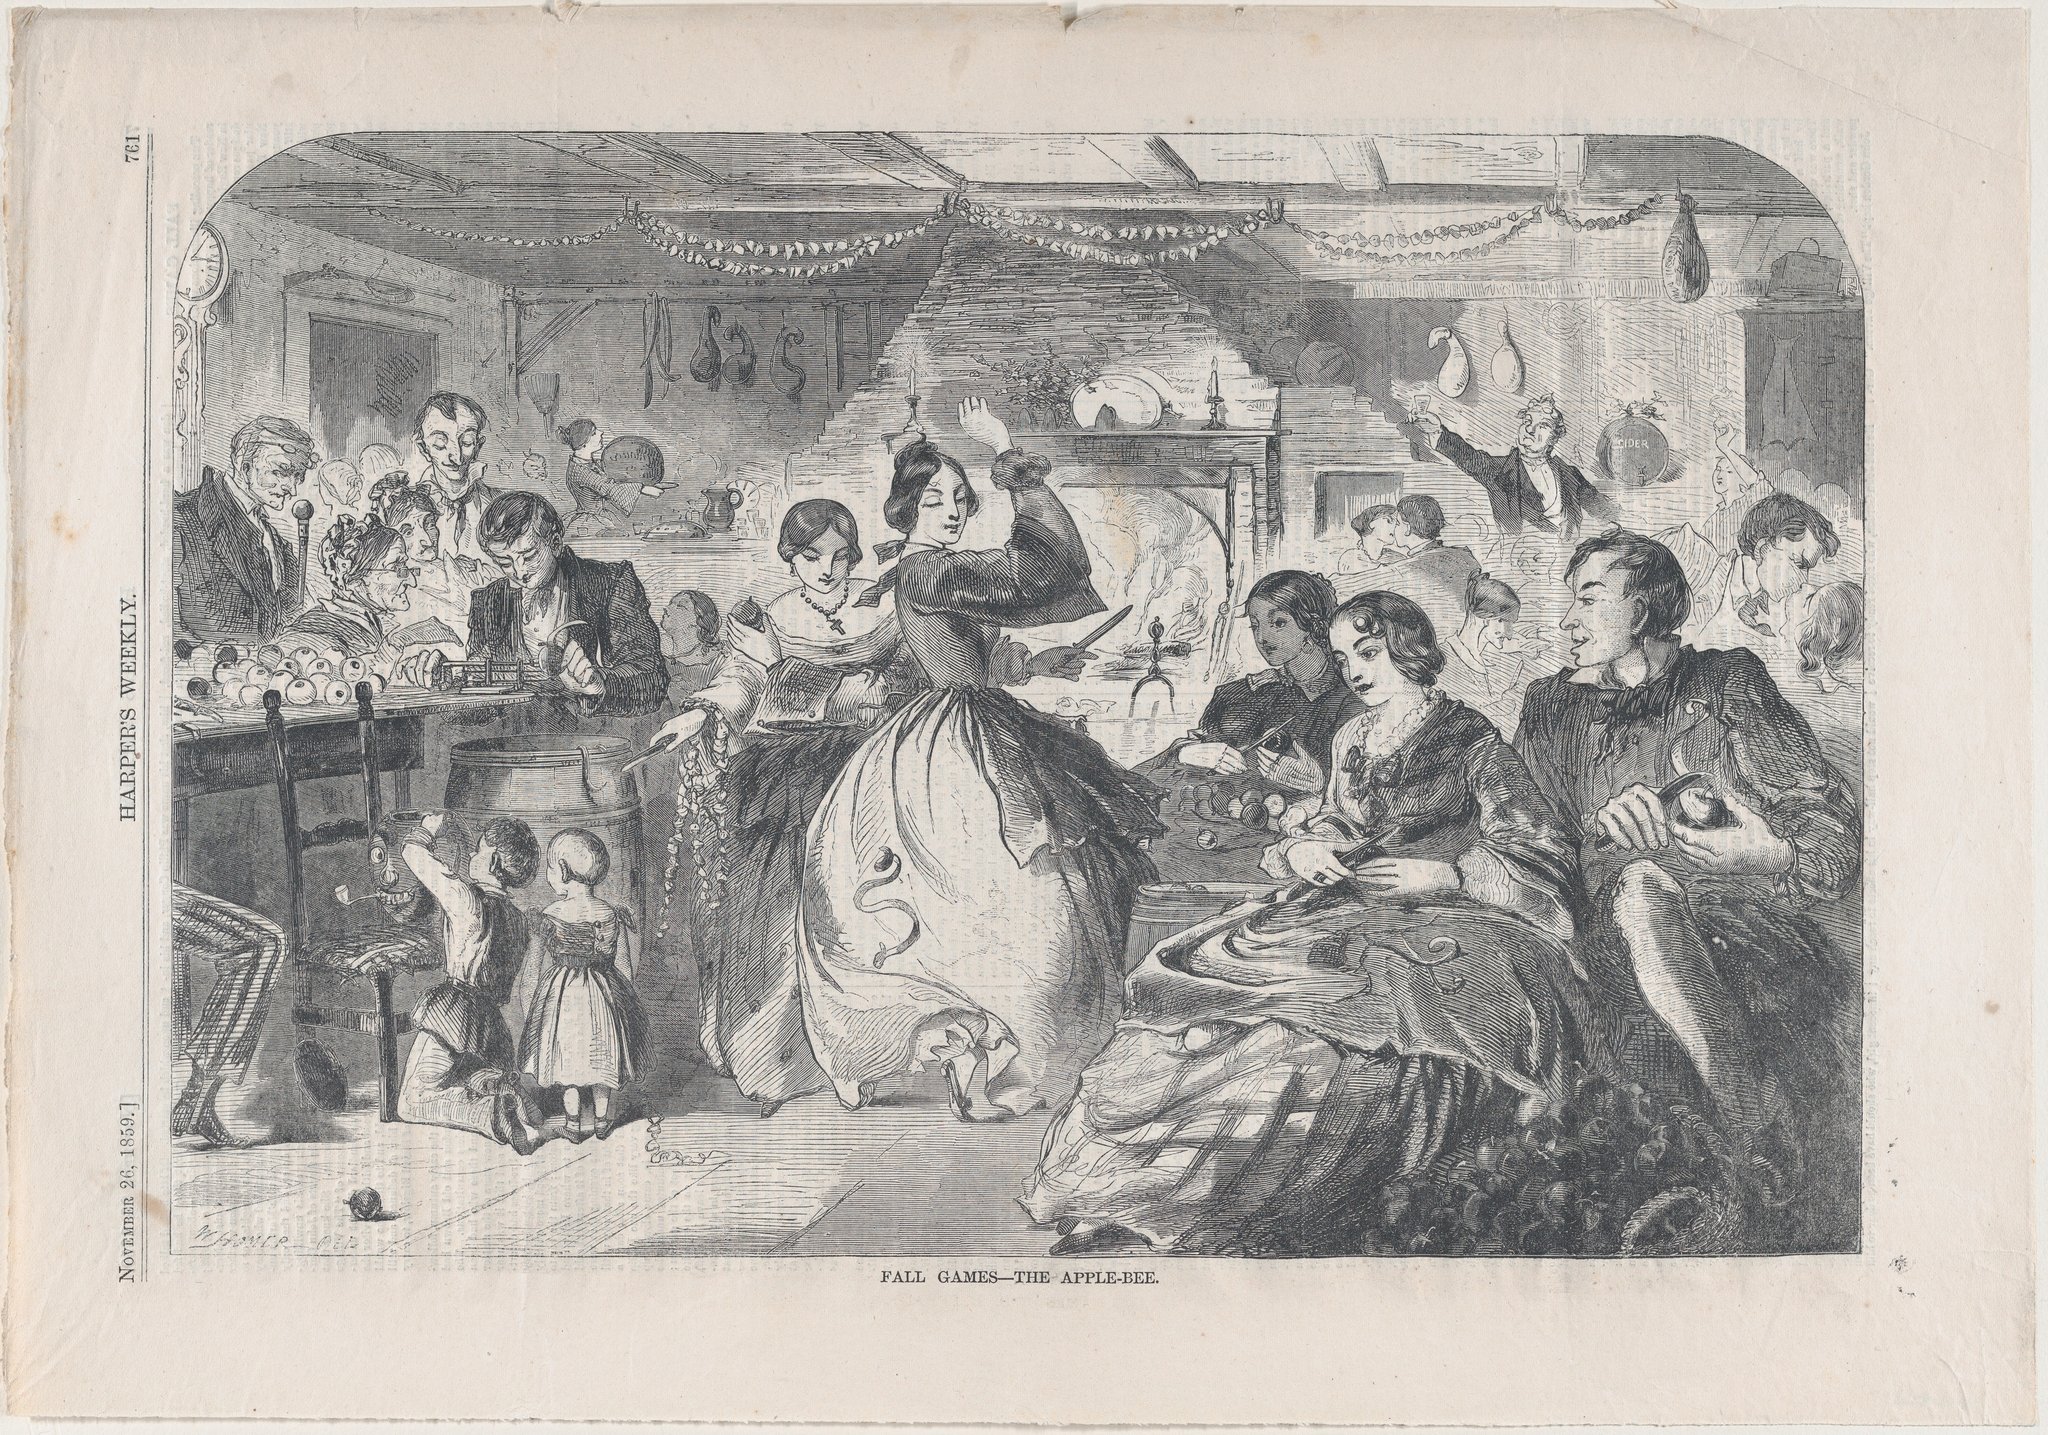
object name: print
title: Fall Games – The Apple Bee (from "Harper's Weekly," Vol. III)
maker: winslow homer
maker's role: artist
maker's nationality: american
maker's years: 1836-1910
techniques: engraving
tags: interiors,children,men,women